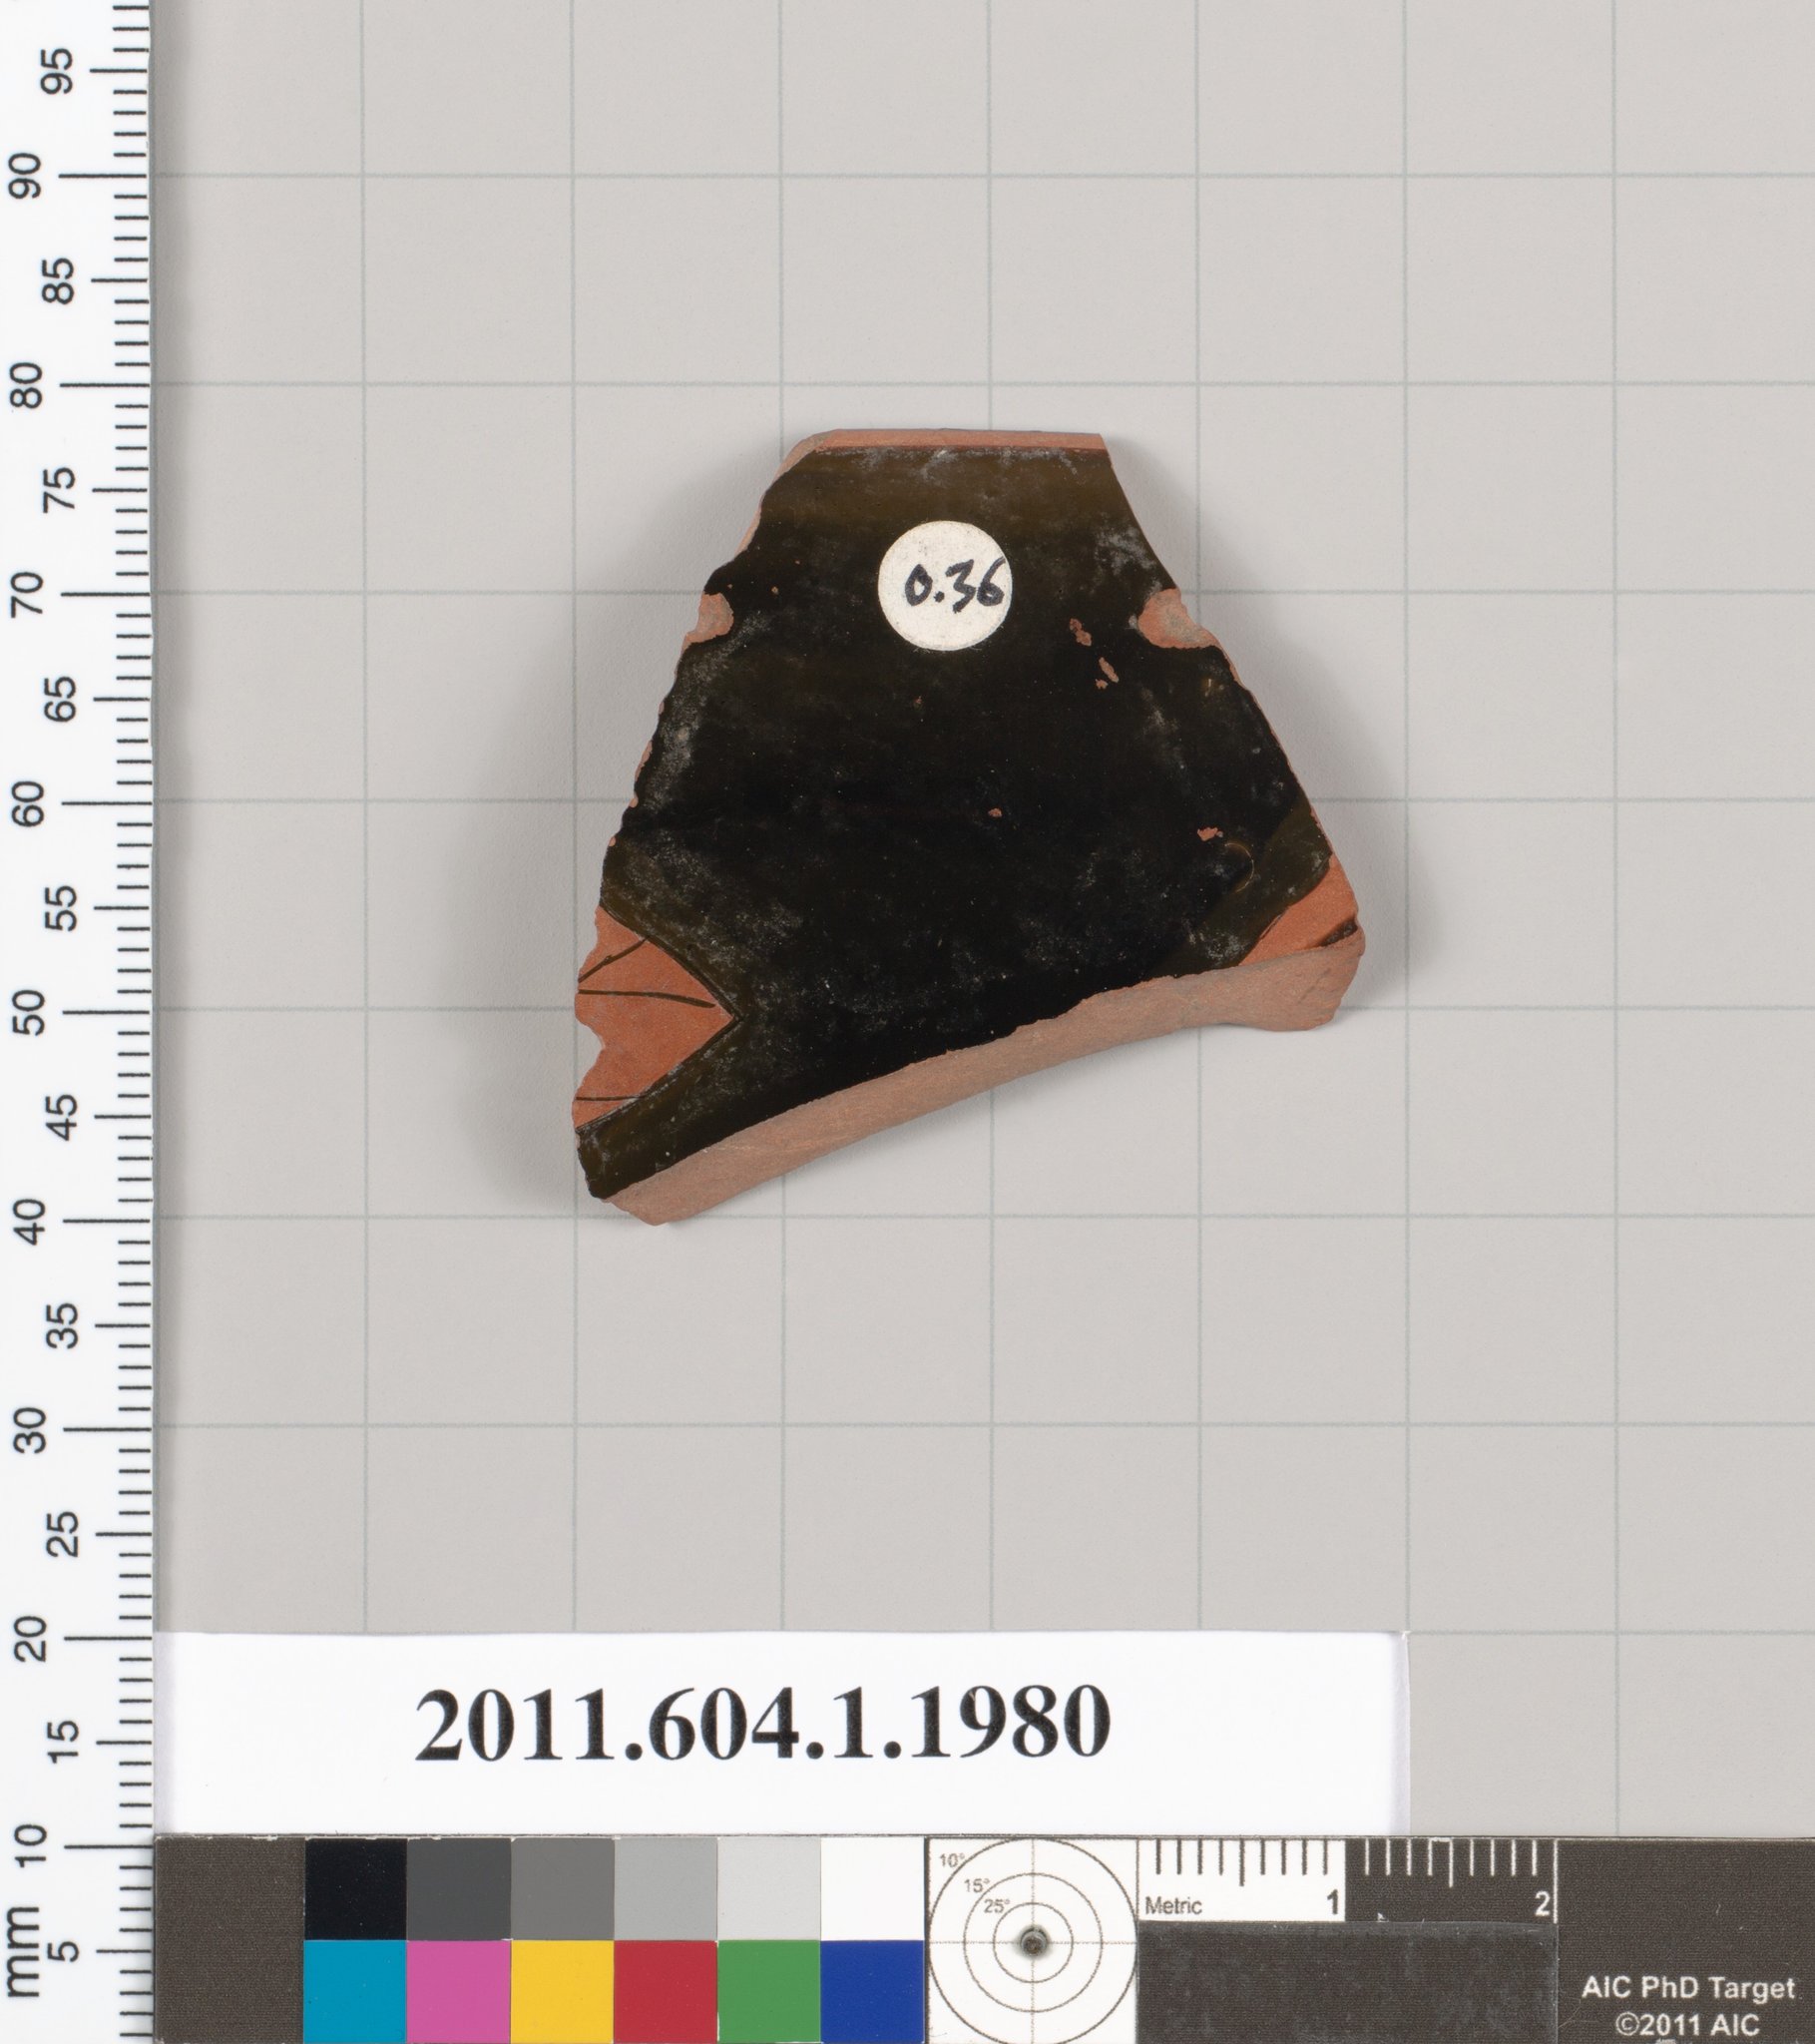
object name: kylix fragment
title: Terracotta rim fragment of a kylix (drinking cup)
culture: greek, attic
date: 475-451 BCE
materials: terracotta